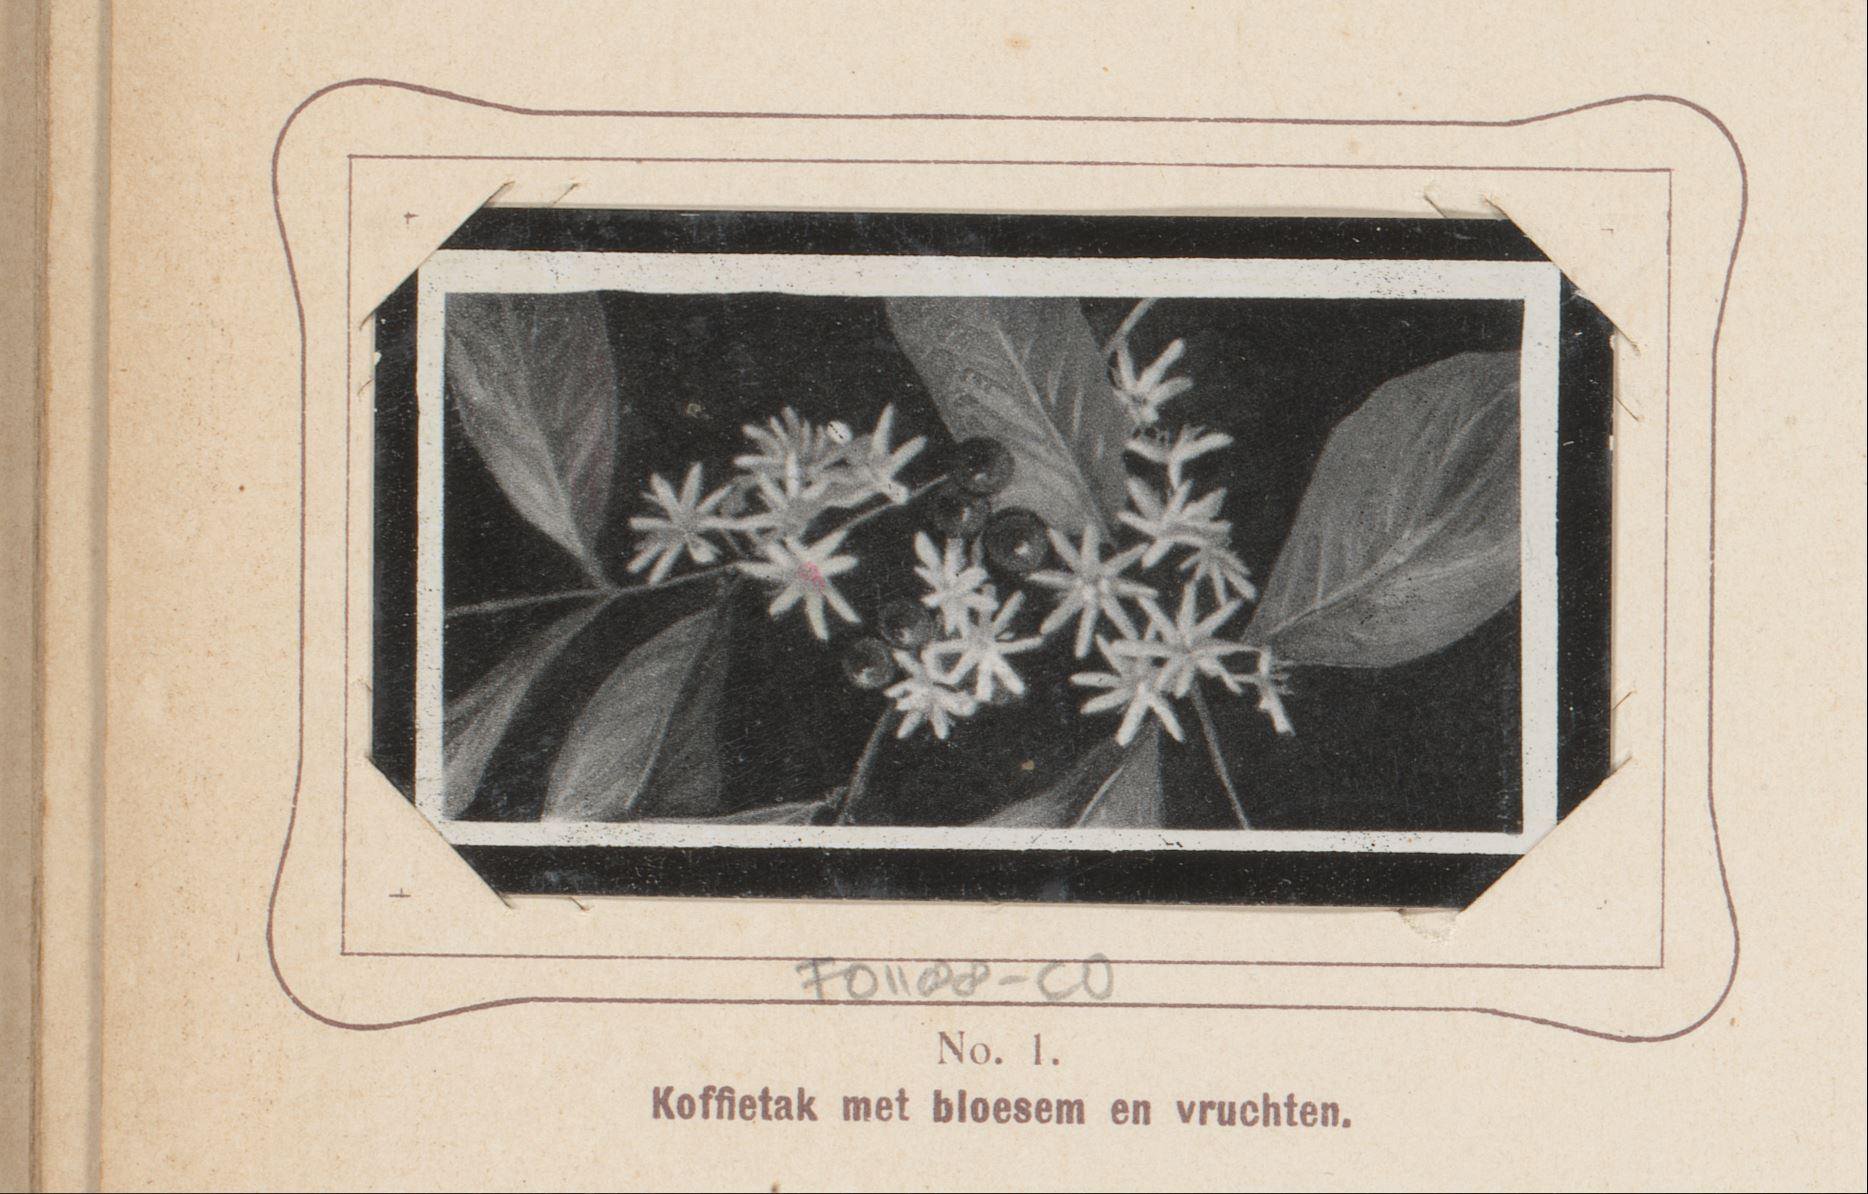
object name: album leaf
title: Koffieplant in bloesem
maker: Anonymous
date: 1906-1907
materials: paper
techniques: photograph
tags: coffee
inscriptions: inscription: ‘No. 1./ Koffietak met bloesem en vruchten.’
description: Deze prent maakt deel uit van een album.